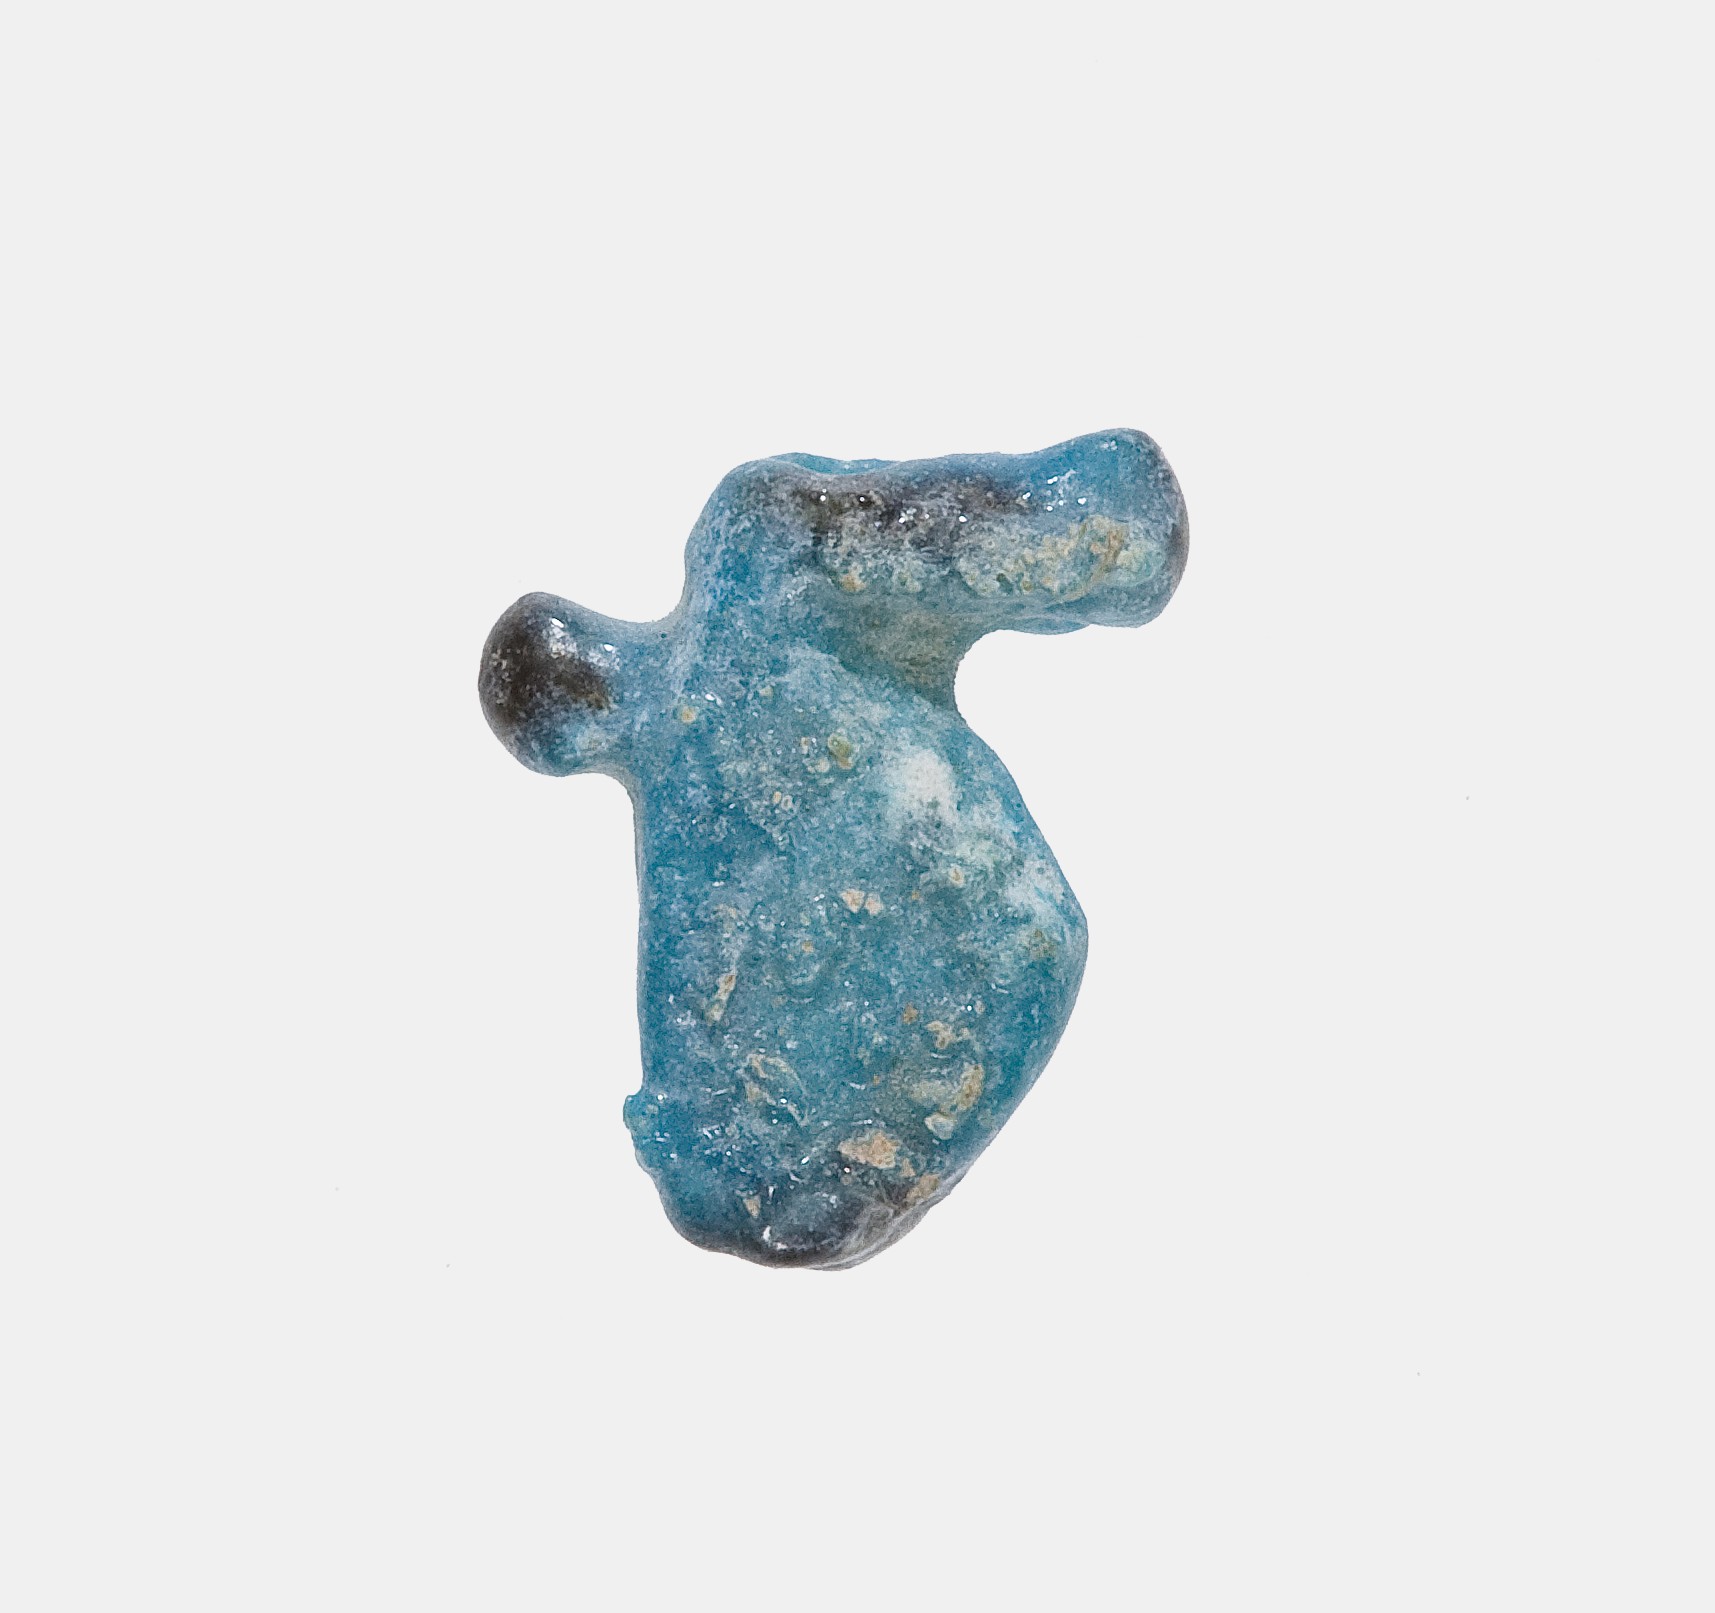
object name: amulet, taweret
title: Taweret (?) Amulet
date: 1802-1450 BCE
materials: faience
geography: egypt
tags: taweret